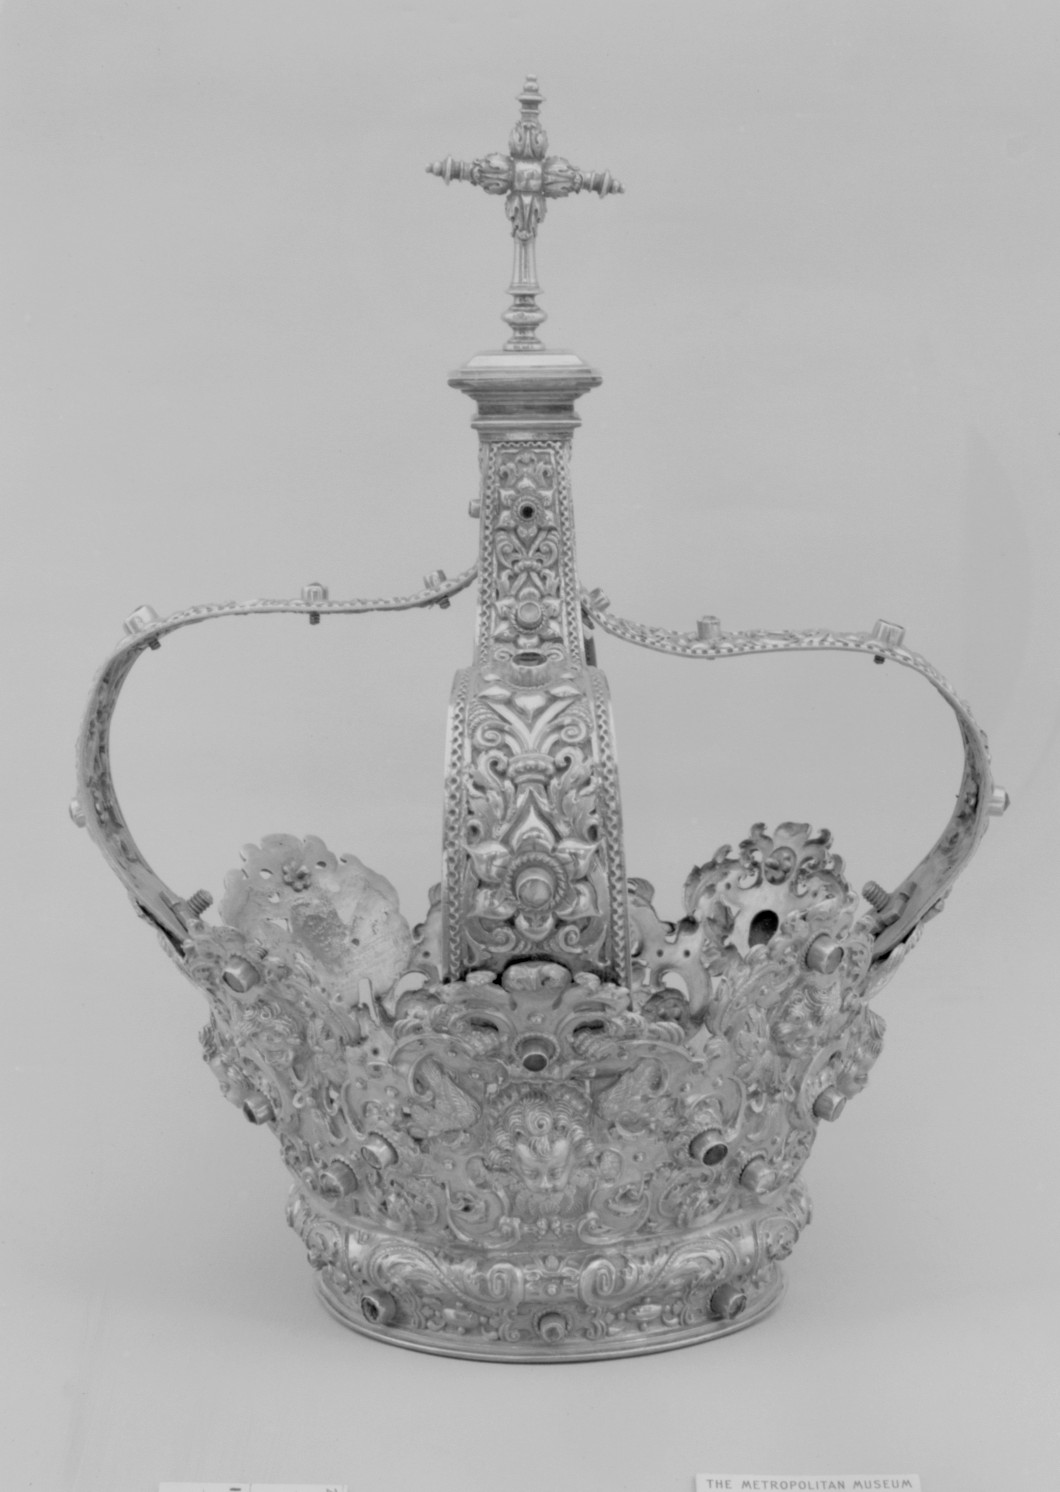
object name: crown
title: Crown for a statue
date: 1701-1800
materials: silver gilt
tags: crowns